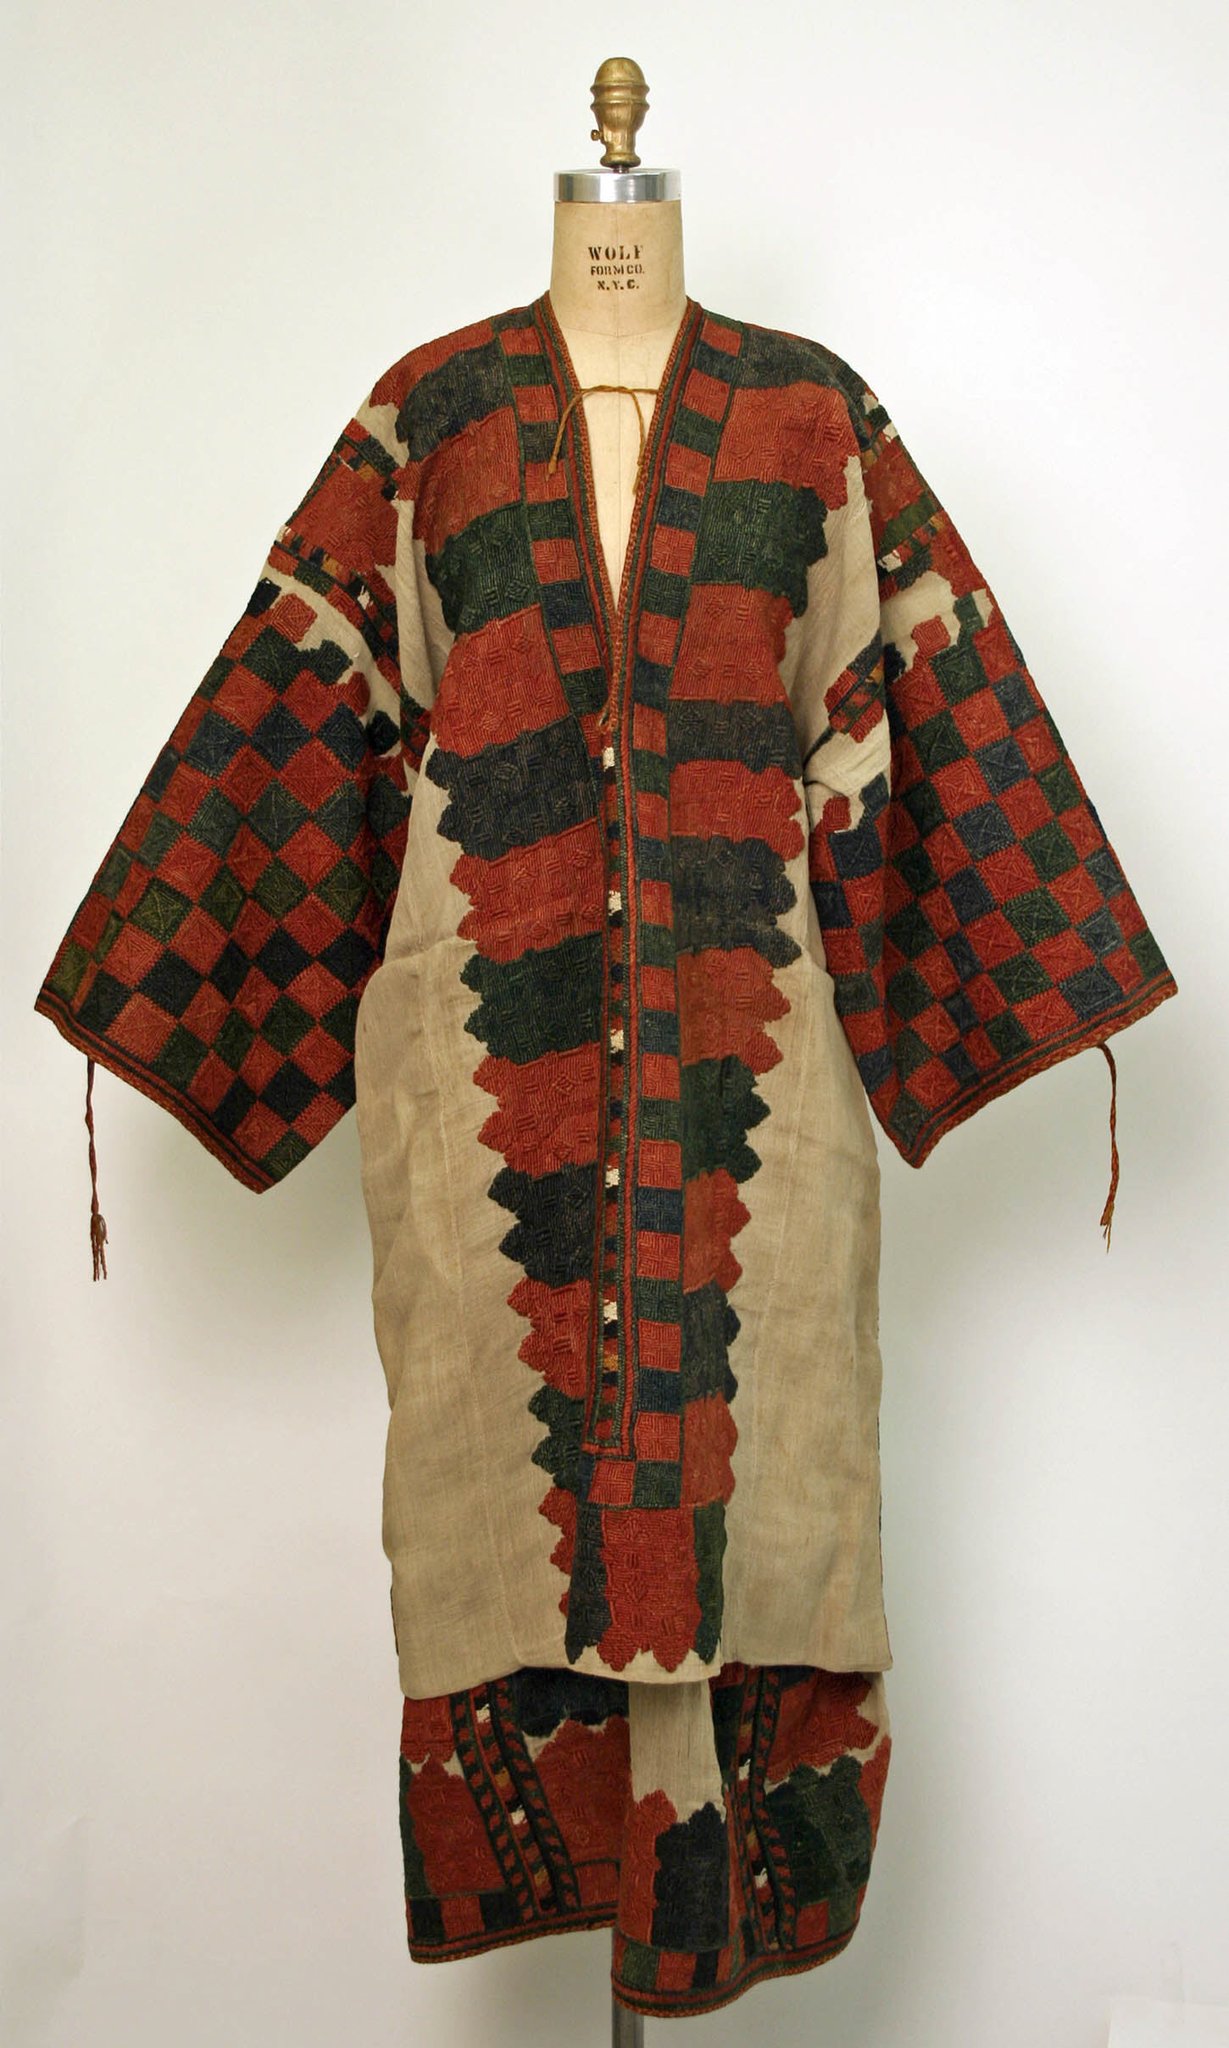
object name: ensemble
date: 1701-1800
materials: linen, silk